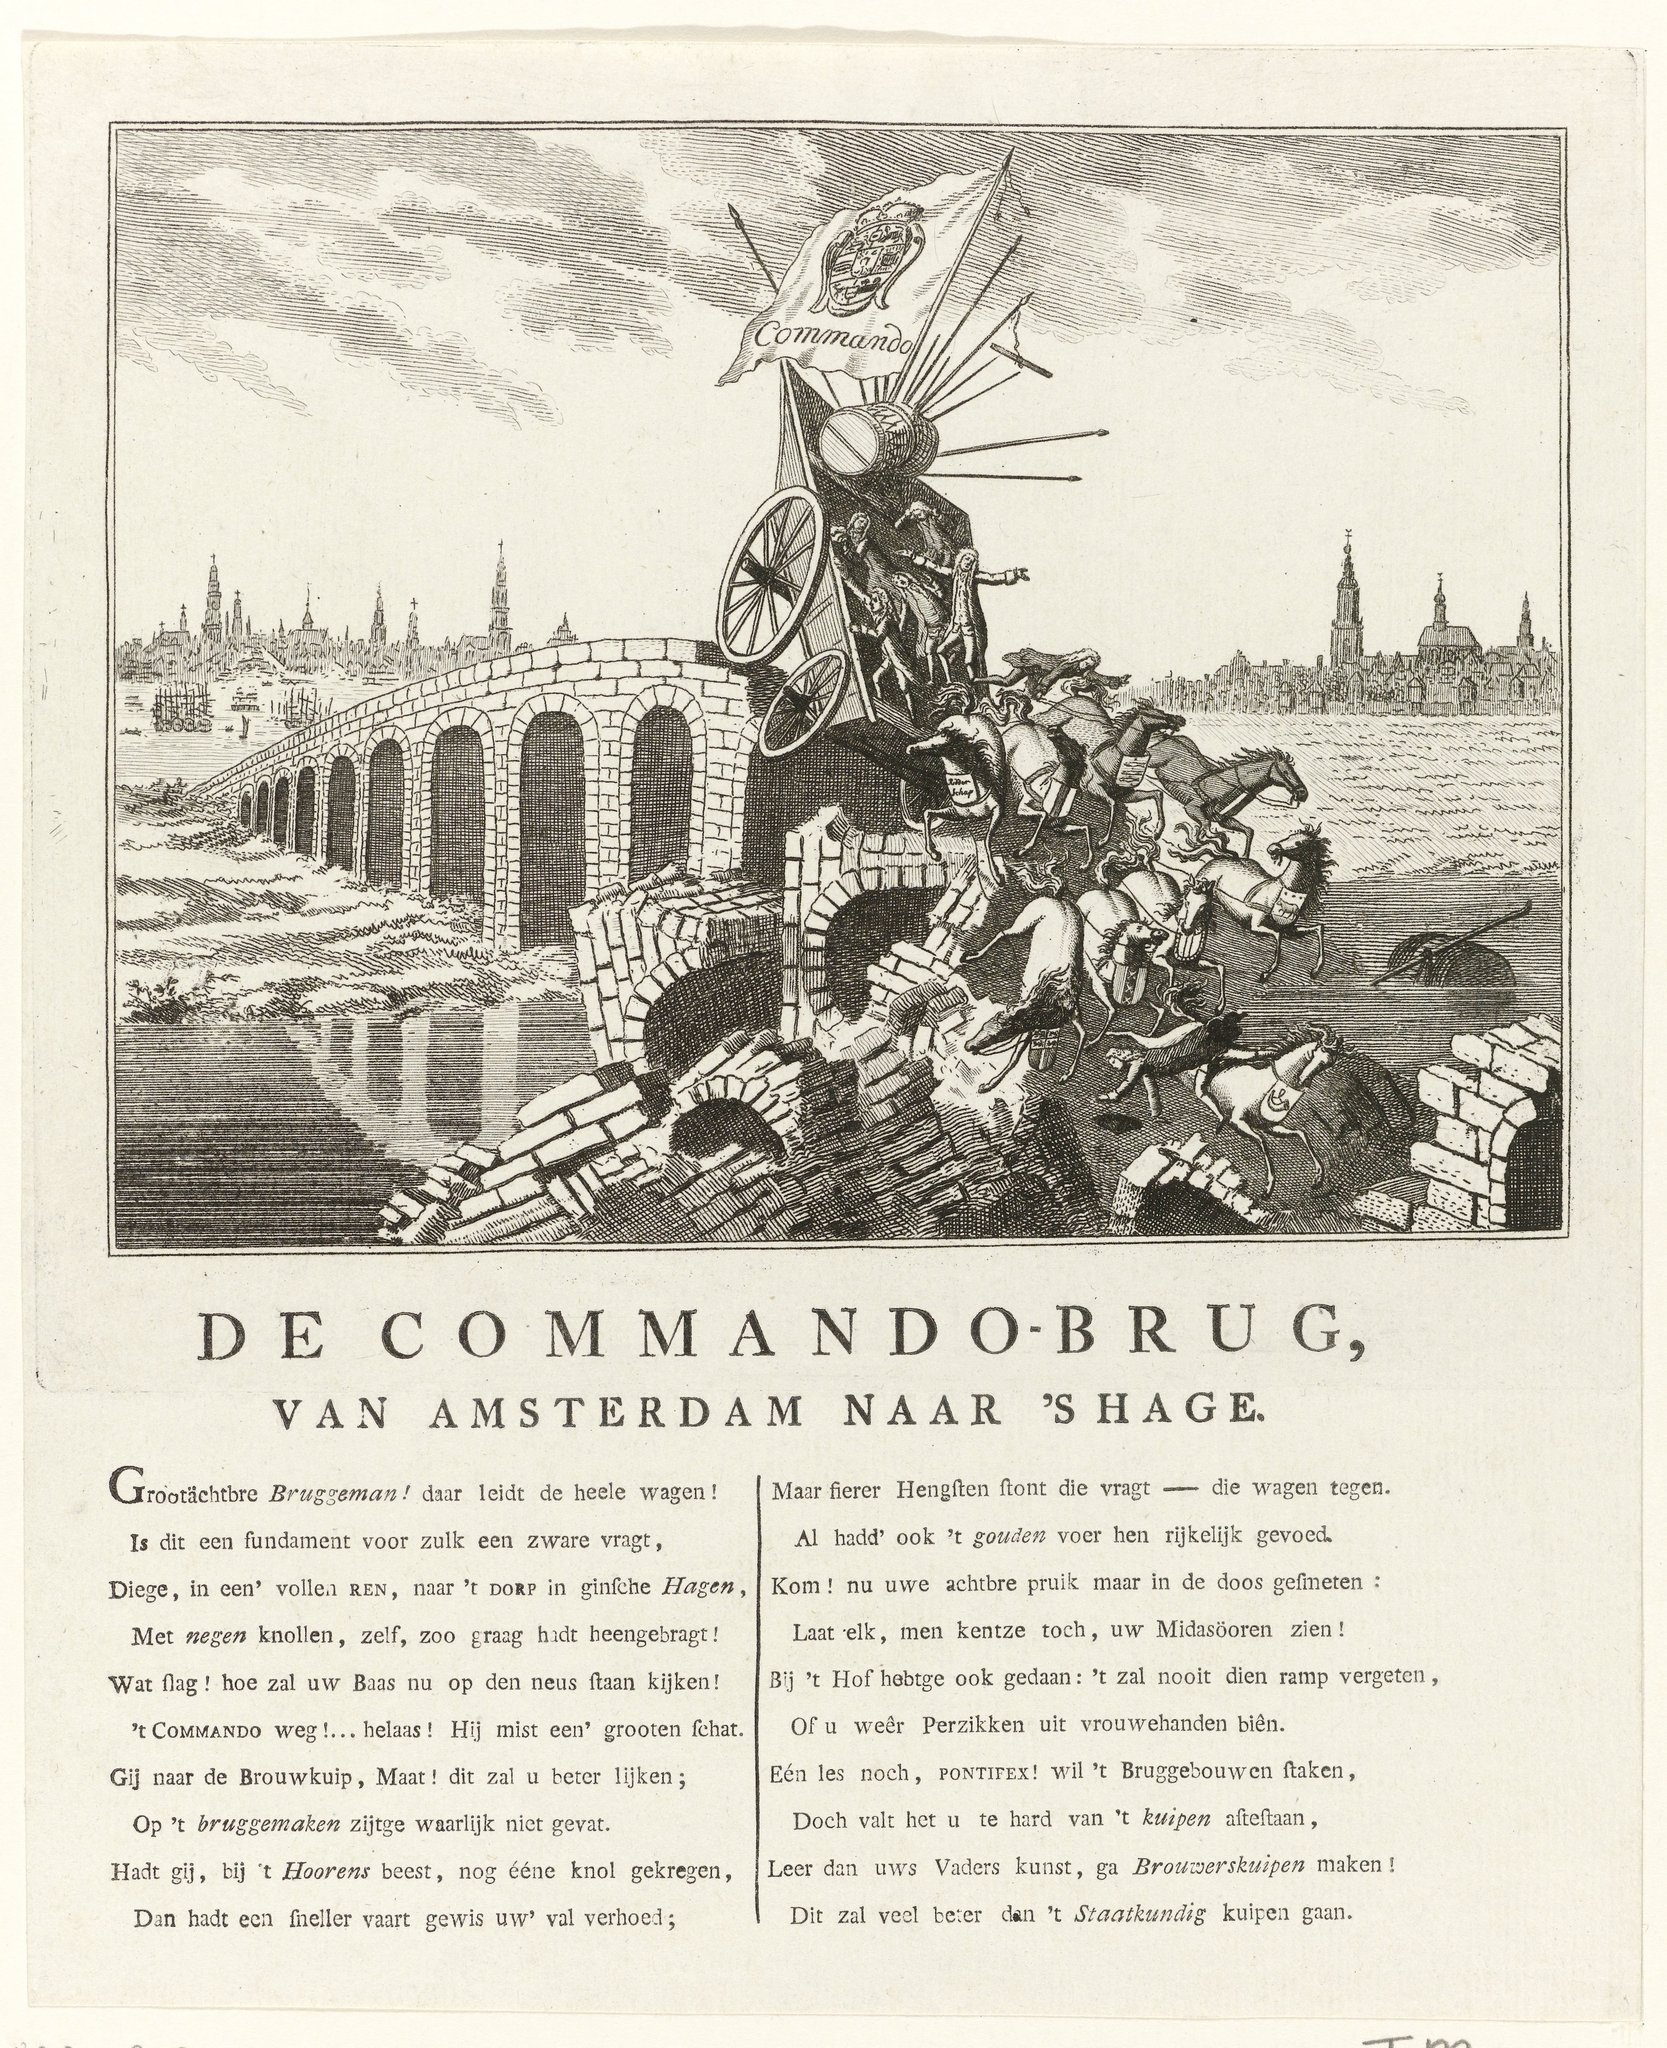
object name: cartoon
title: Spotprent op Rendorp en anderen die stemden tegen het ontnemen van het commando over Den Haag aan de prins, 1786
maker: Anonymous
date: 1786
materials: paper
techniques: engraving, etching, letterpress printing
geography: northern netherlands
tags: the hague, william v (prince of orange), mayor, joachim rendorp, bridge (+ accident, collision, crash ~ traffic and transport), collapsing building, amsterdam, patriots (1780-1795)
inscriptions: collector's mark: Lugt 2228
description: Spotprent op de Amsterdamse burgemeester Joachim Rendorp (bijgenaamd De Bruggenmaker), de acht steden en de Ridderschap die stemden tegen het ontnemen van het commando over Den Haag aan de prins (voorstel van september 1785, het definitieve besluit hierover dateert echter van juli-september 1786). Een wagen met het wapen van de prins en getrokken door negen paarden stort in de diepte als de brug waarover zij rijdt instort. In de verte het profiel van Amsterdam. Op het blad onder de plaat een vers van 20 regels in 2 kolommen.